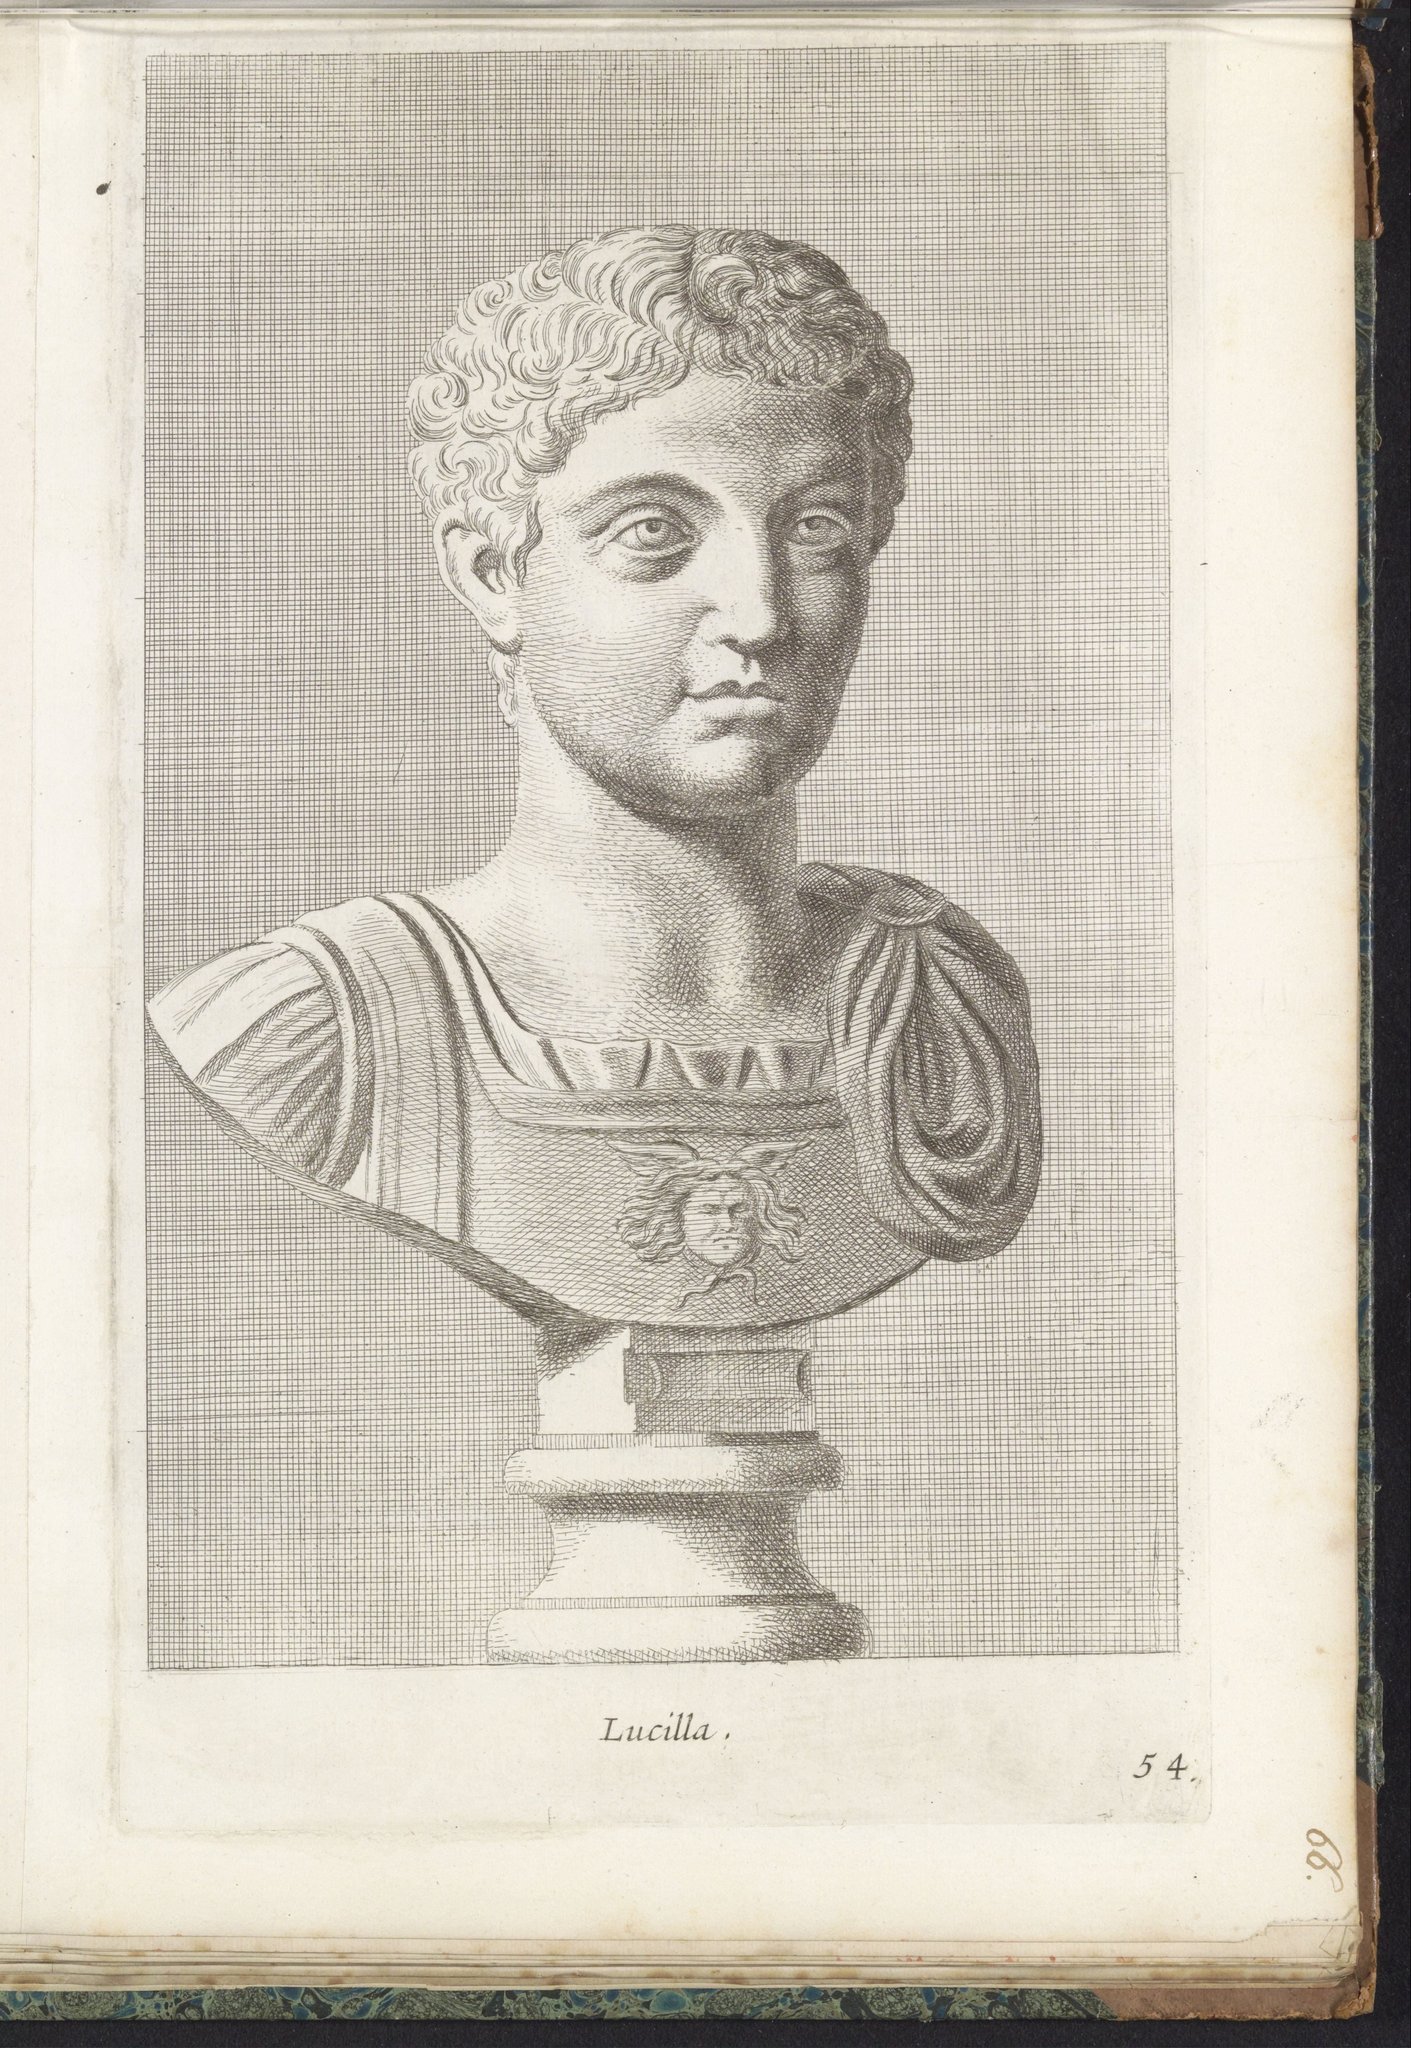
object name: album leaf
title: Lucilla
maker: hubert quellinus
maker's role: print maker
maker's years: 1619-1687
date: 1646-1670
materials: paper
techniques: engraving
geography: antwerp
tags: piece of sculpture, reproduction of a piece of sculpture, male persons from classical history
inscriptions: number: ‘66’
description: Klassieke buste van een jonge man. De prent maakt deel uit van een album met een serie prenten naar de sculpturen in de verzameling van Gerard Reynst.